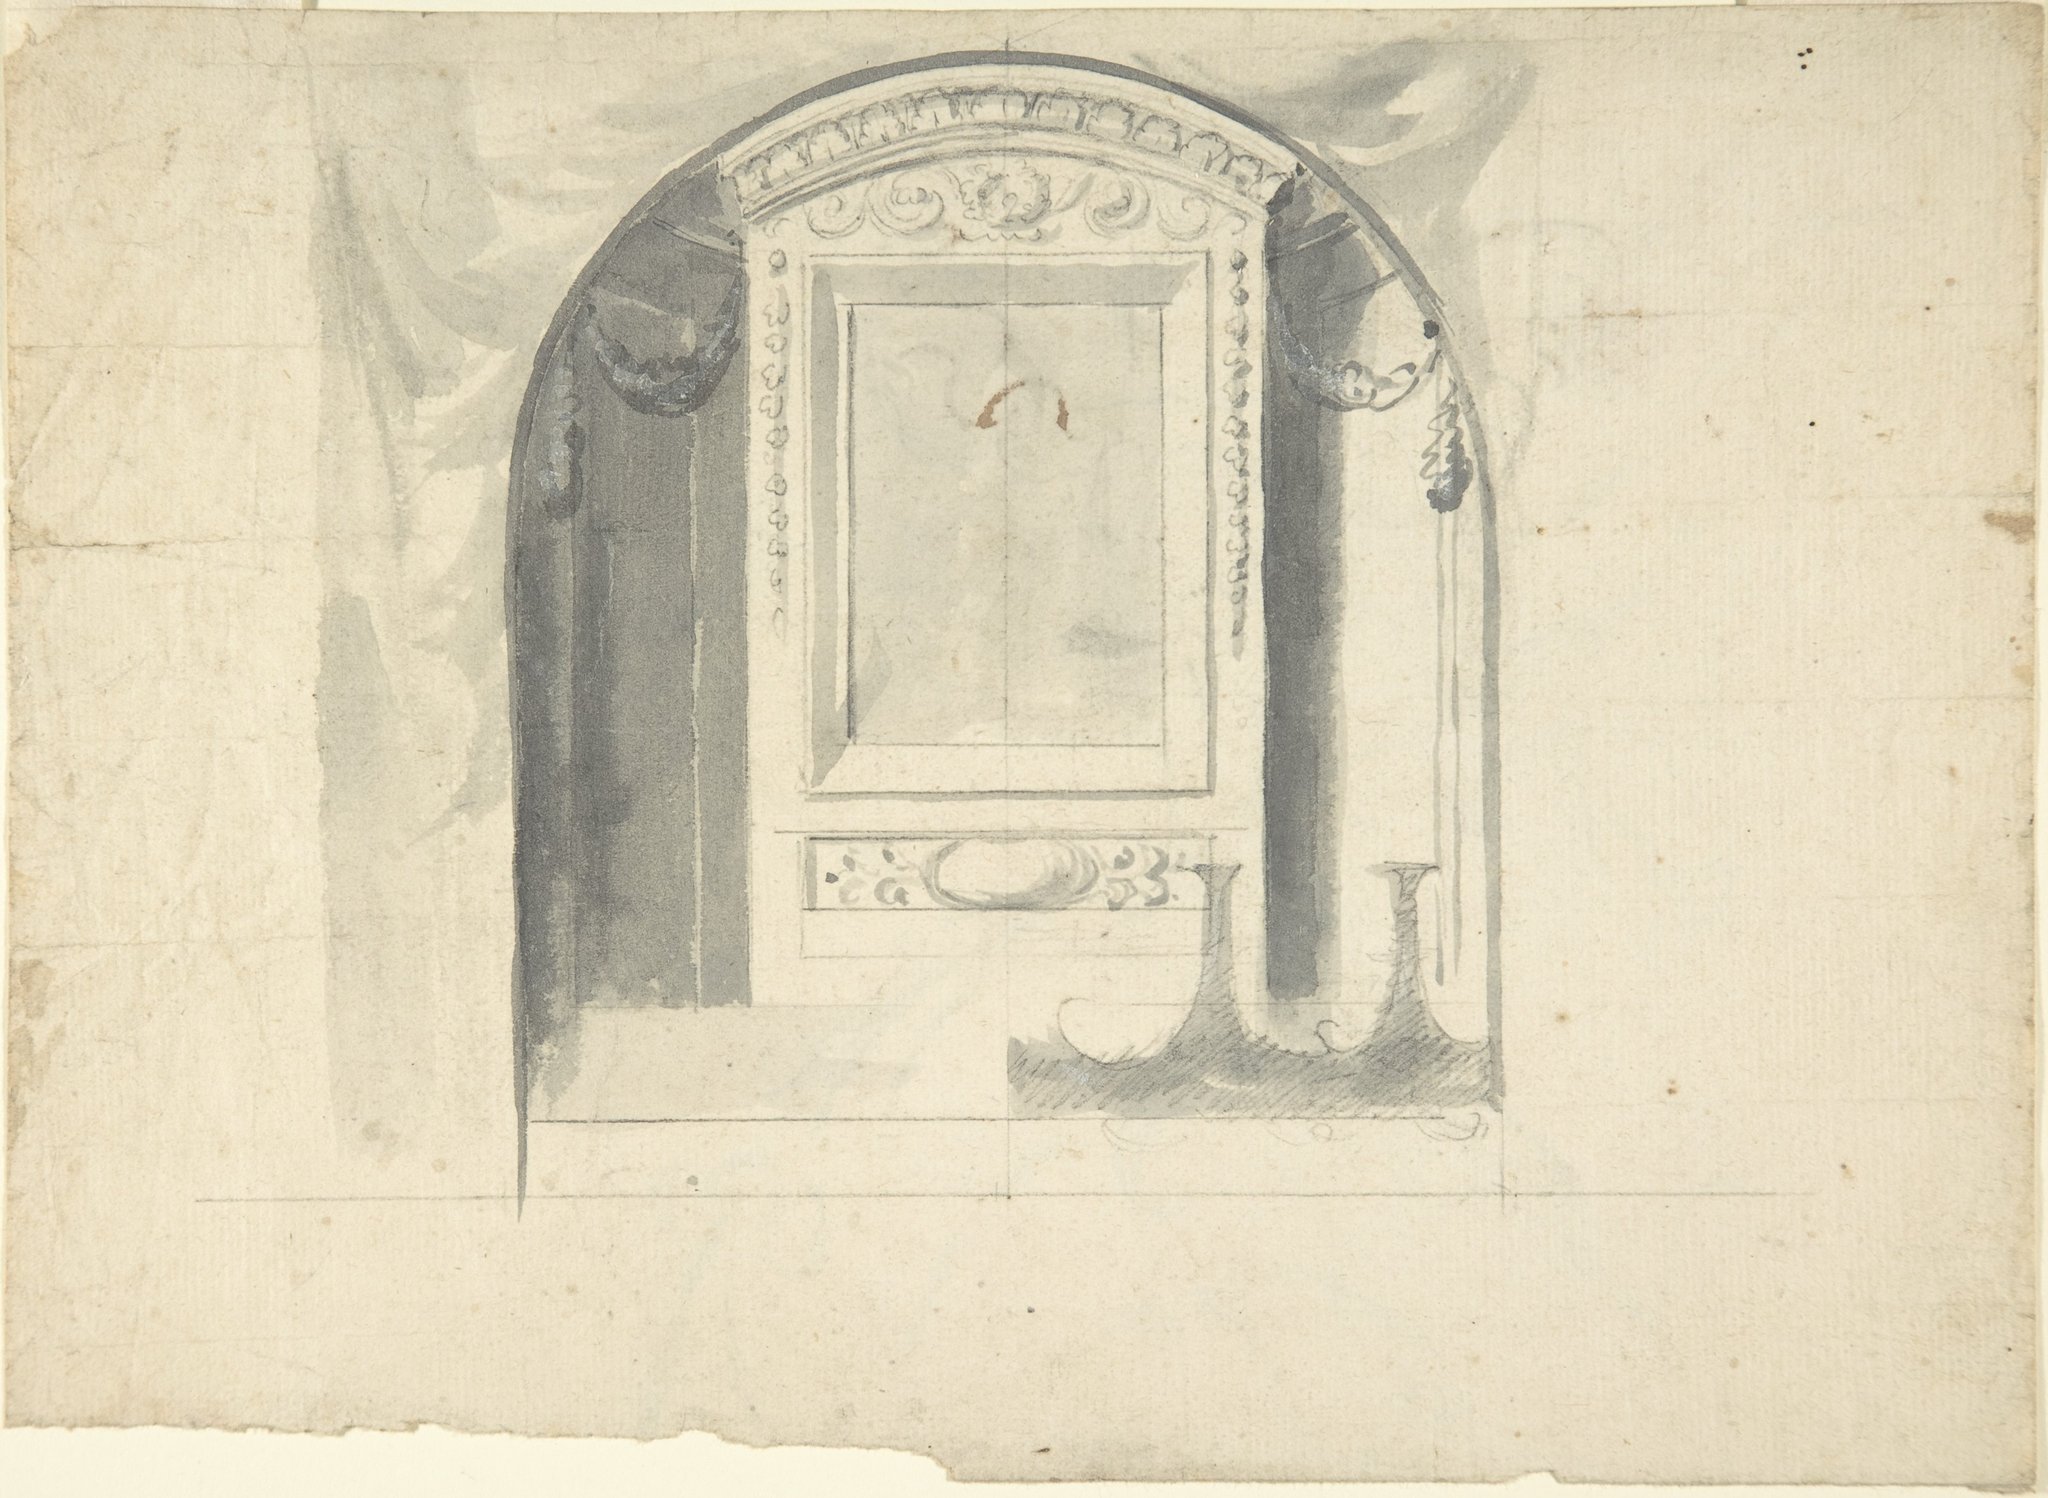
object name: drawing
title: Design for a Chapel or Niche (Recto); Design for Decoration with Putto Head and Rinceau (Verso)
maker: anonymous, italian, 17th century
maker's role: artist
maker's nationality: italian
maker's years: 1600-1700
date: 1601-1700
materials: chalk, graphite, ink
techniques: brush, pen, drawing